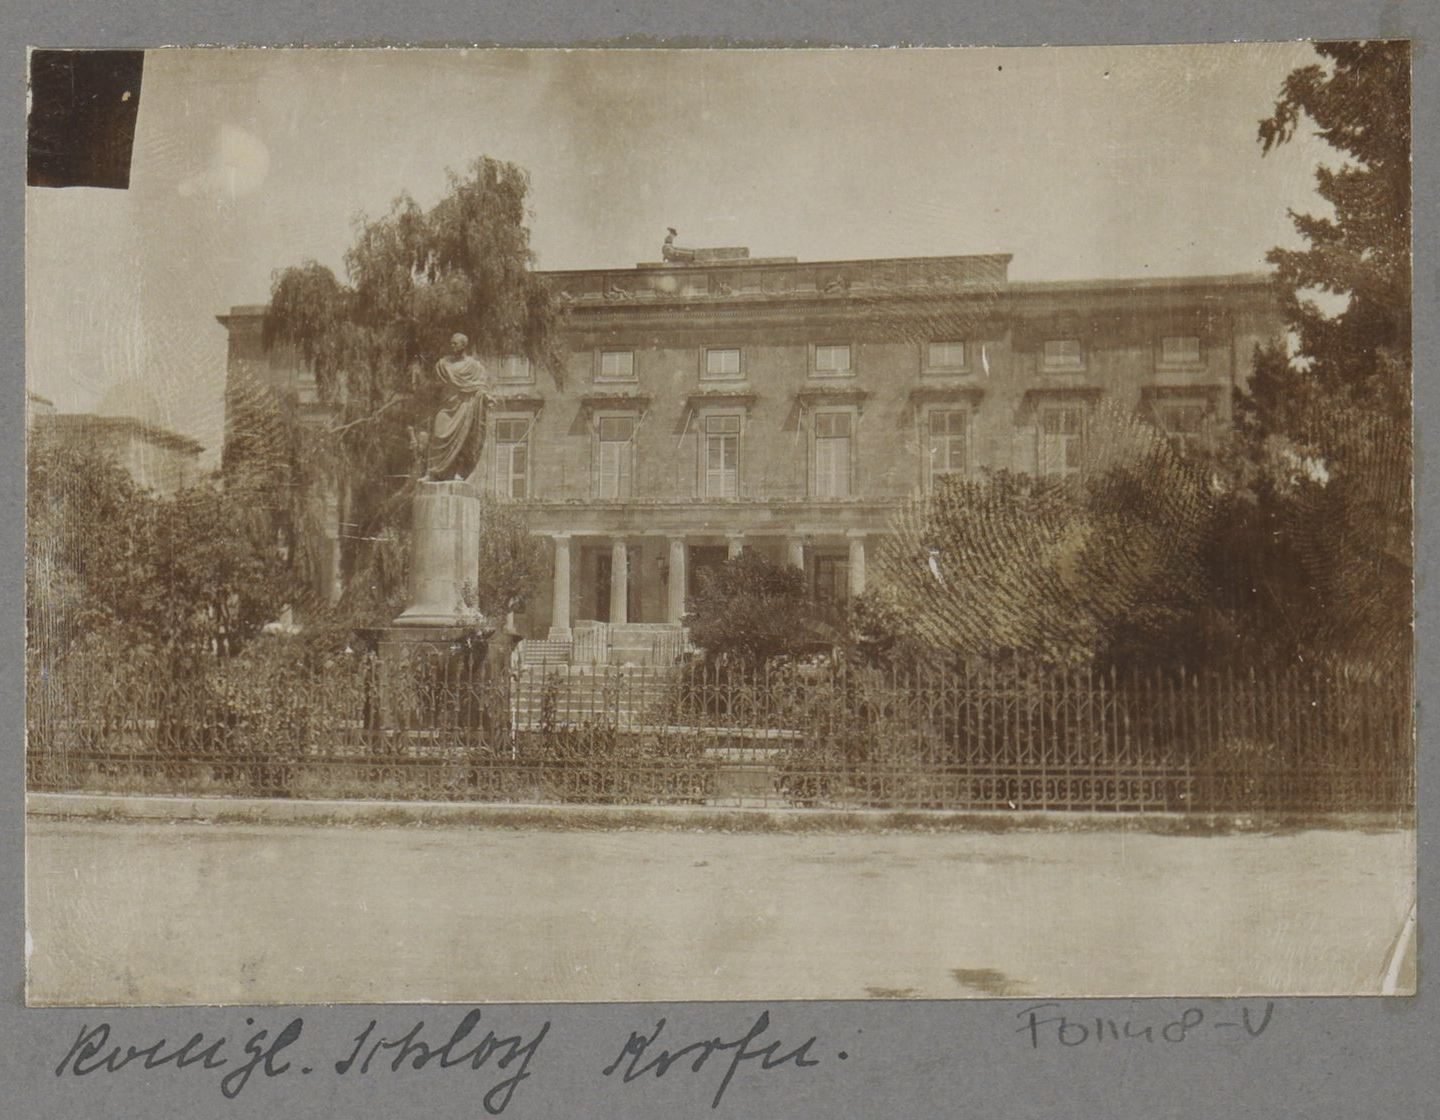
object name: album leaf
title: Gevel van het koninklijk slot op Corfu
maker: Anonymous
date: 1905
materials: paper, photographic support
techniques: collodion silver print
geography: corfu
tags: palace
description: Onderdeel van Reisalbum met foto's van bezienswaardigheden in Griekenland en Egypte.